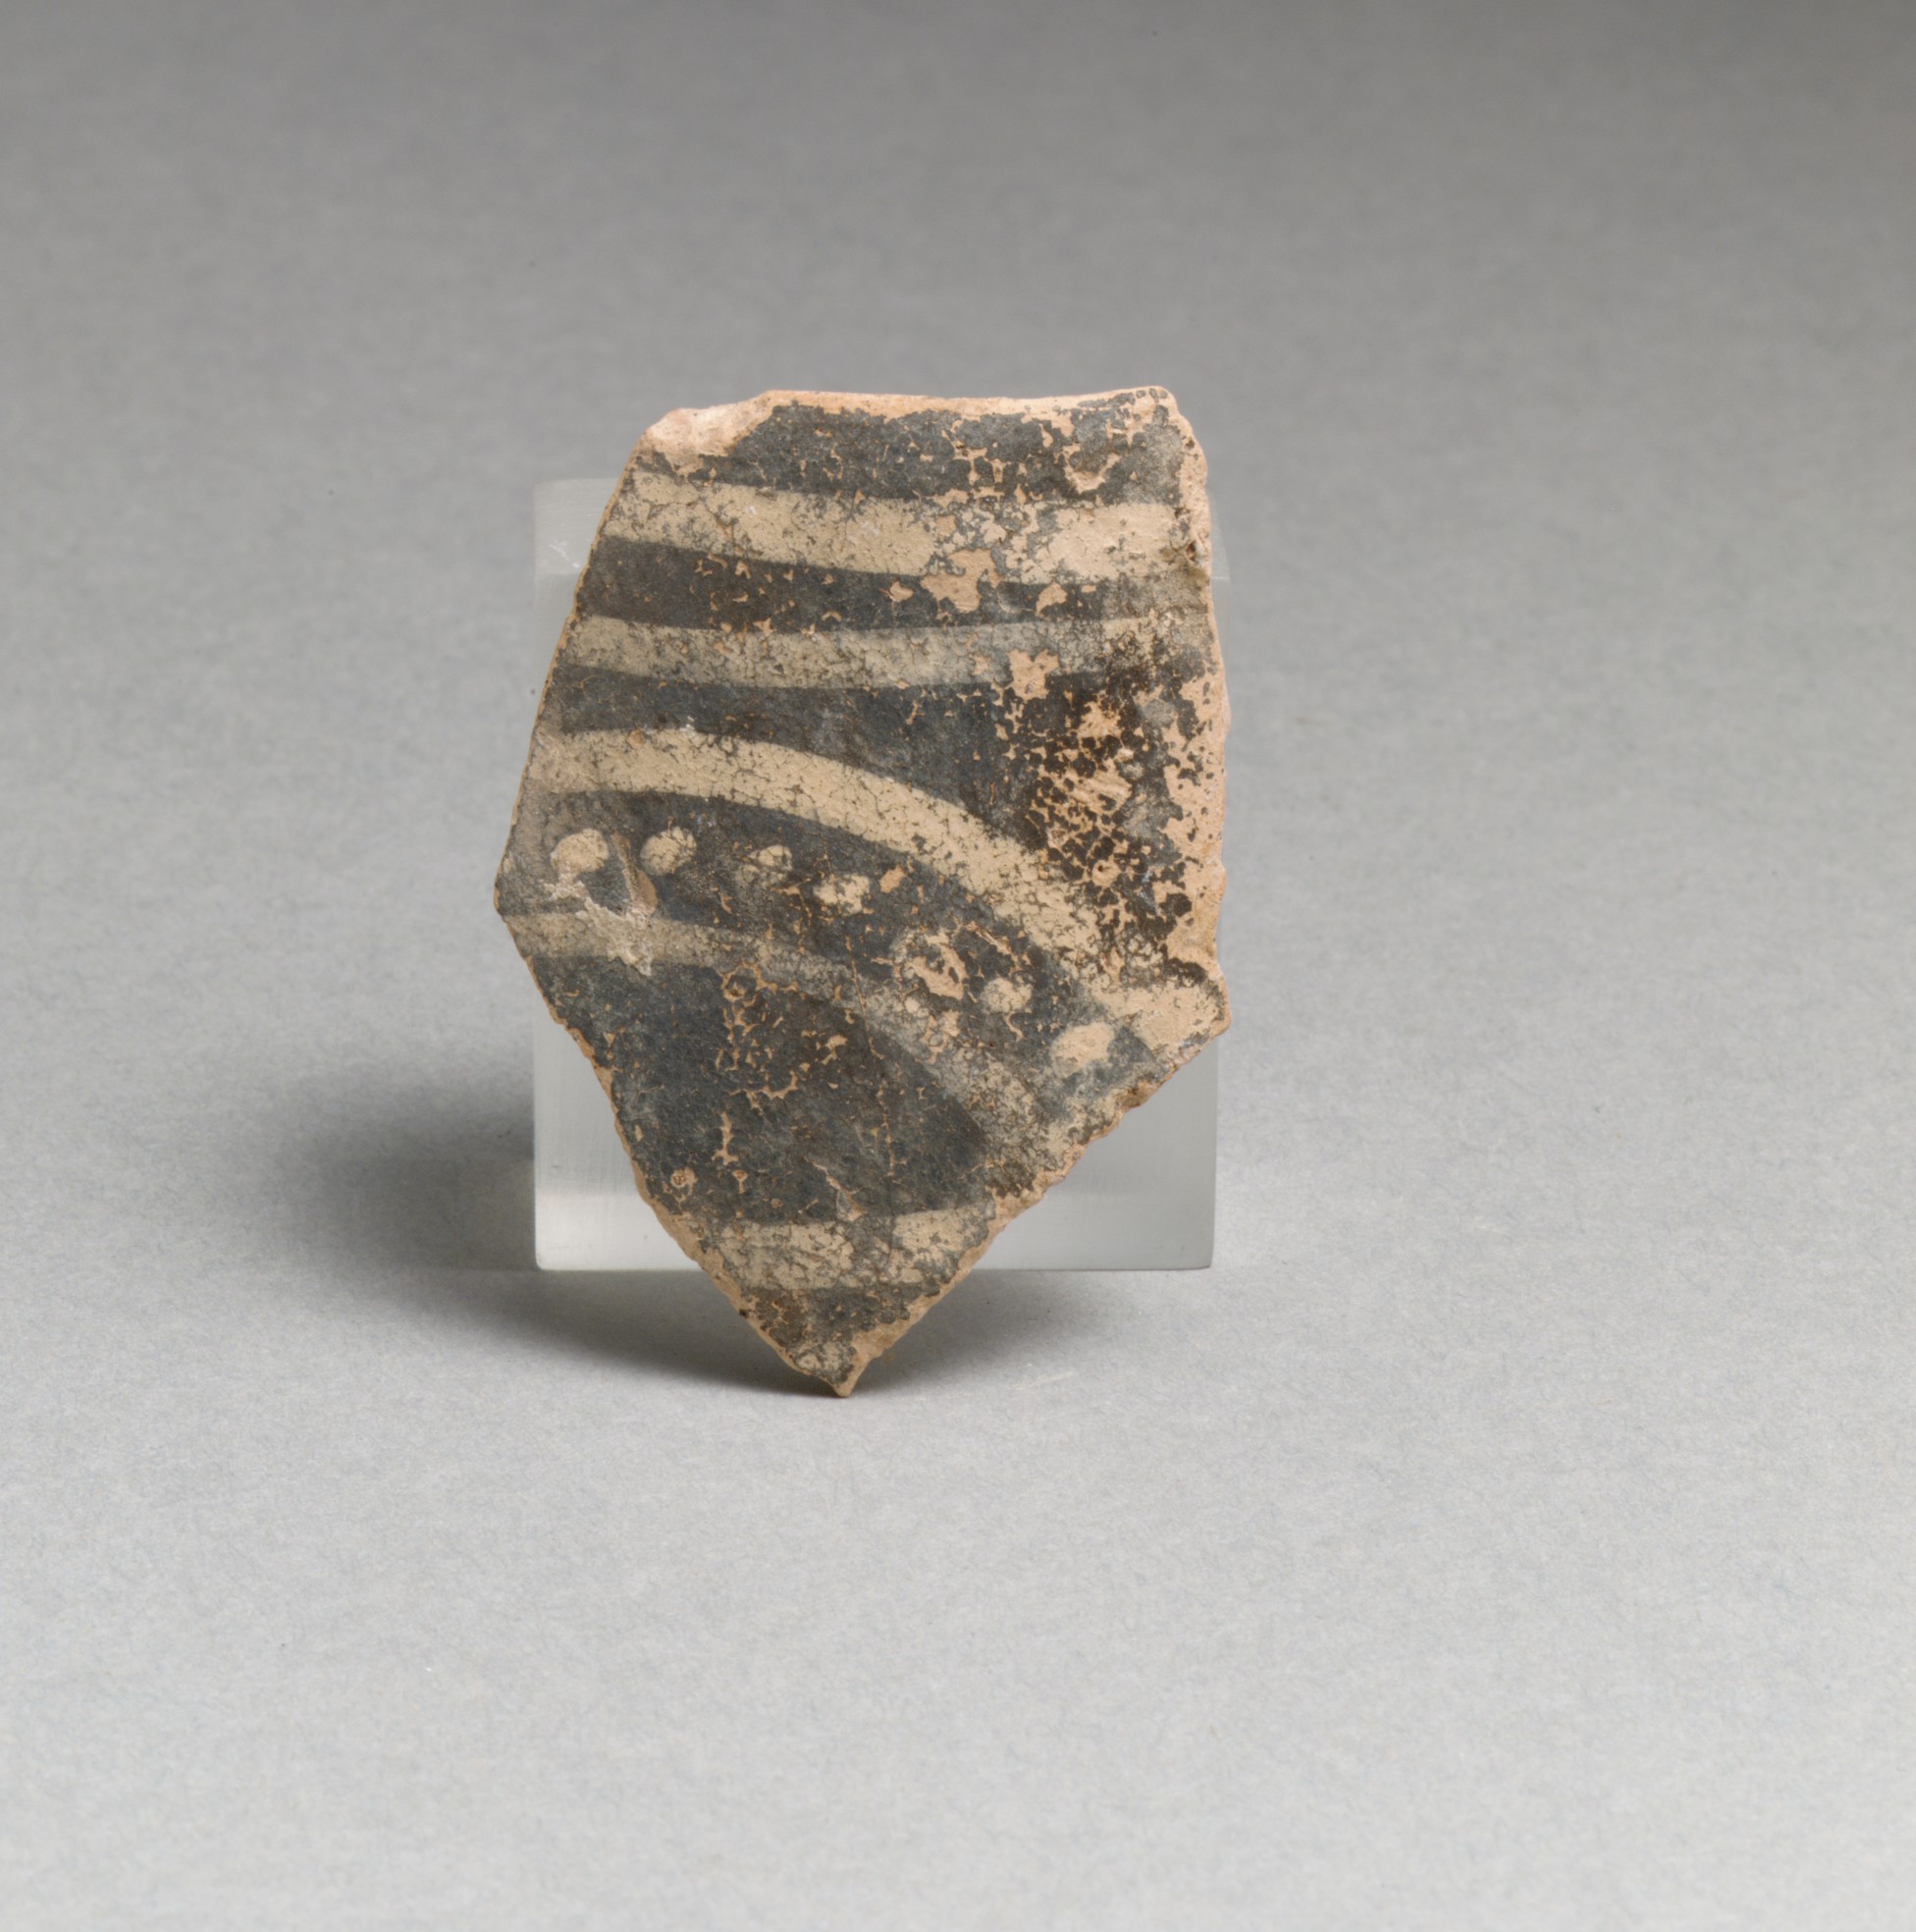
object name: vase fragment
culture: minoan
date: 2600-2000 BCE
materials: terracotta